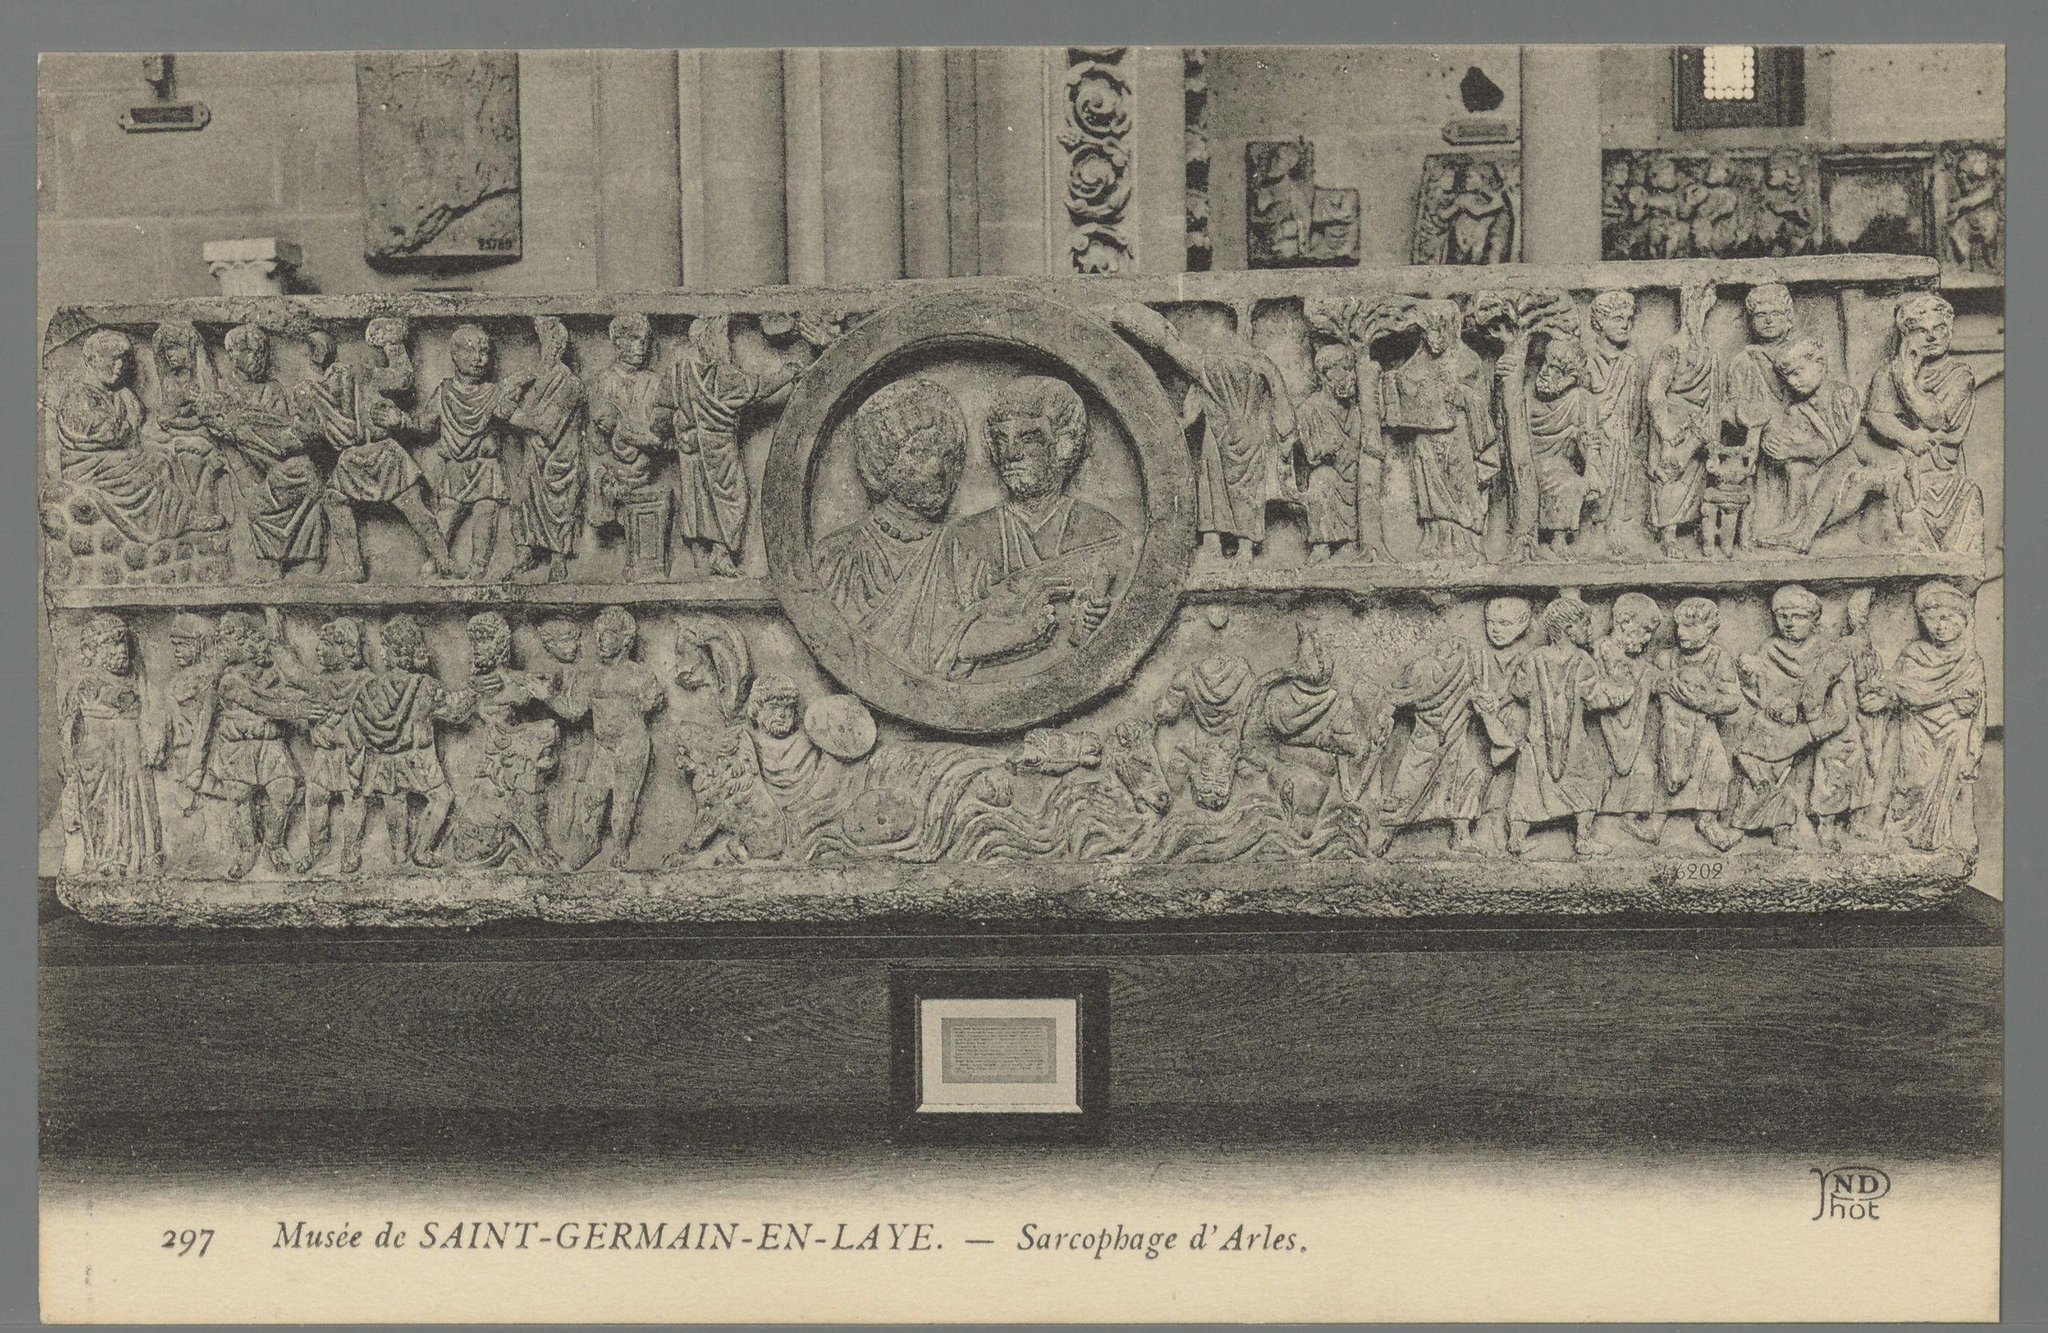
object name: ansichtkaart, prentbriefkaart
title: Sarcophage d'Arles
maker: Anonymous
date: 1903-1918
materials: cardboard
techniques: photograph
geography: paris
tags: sarcophagus, permanent exhibition, museum